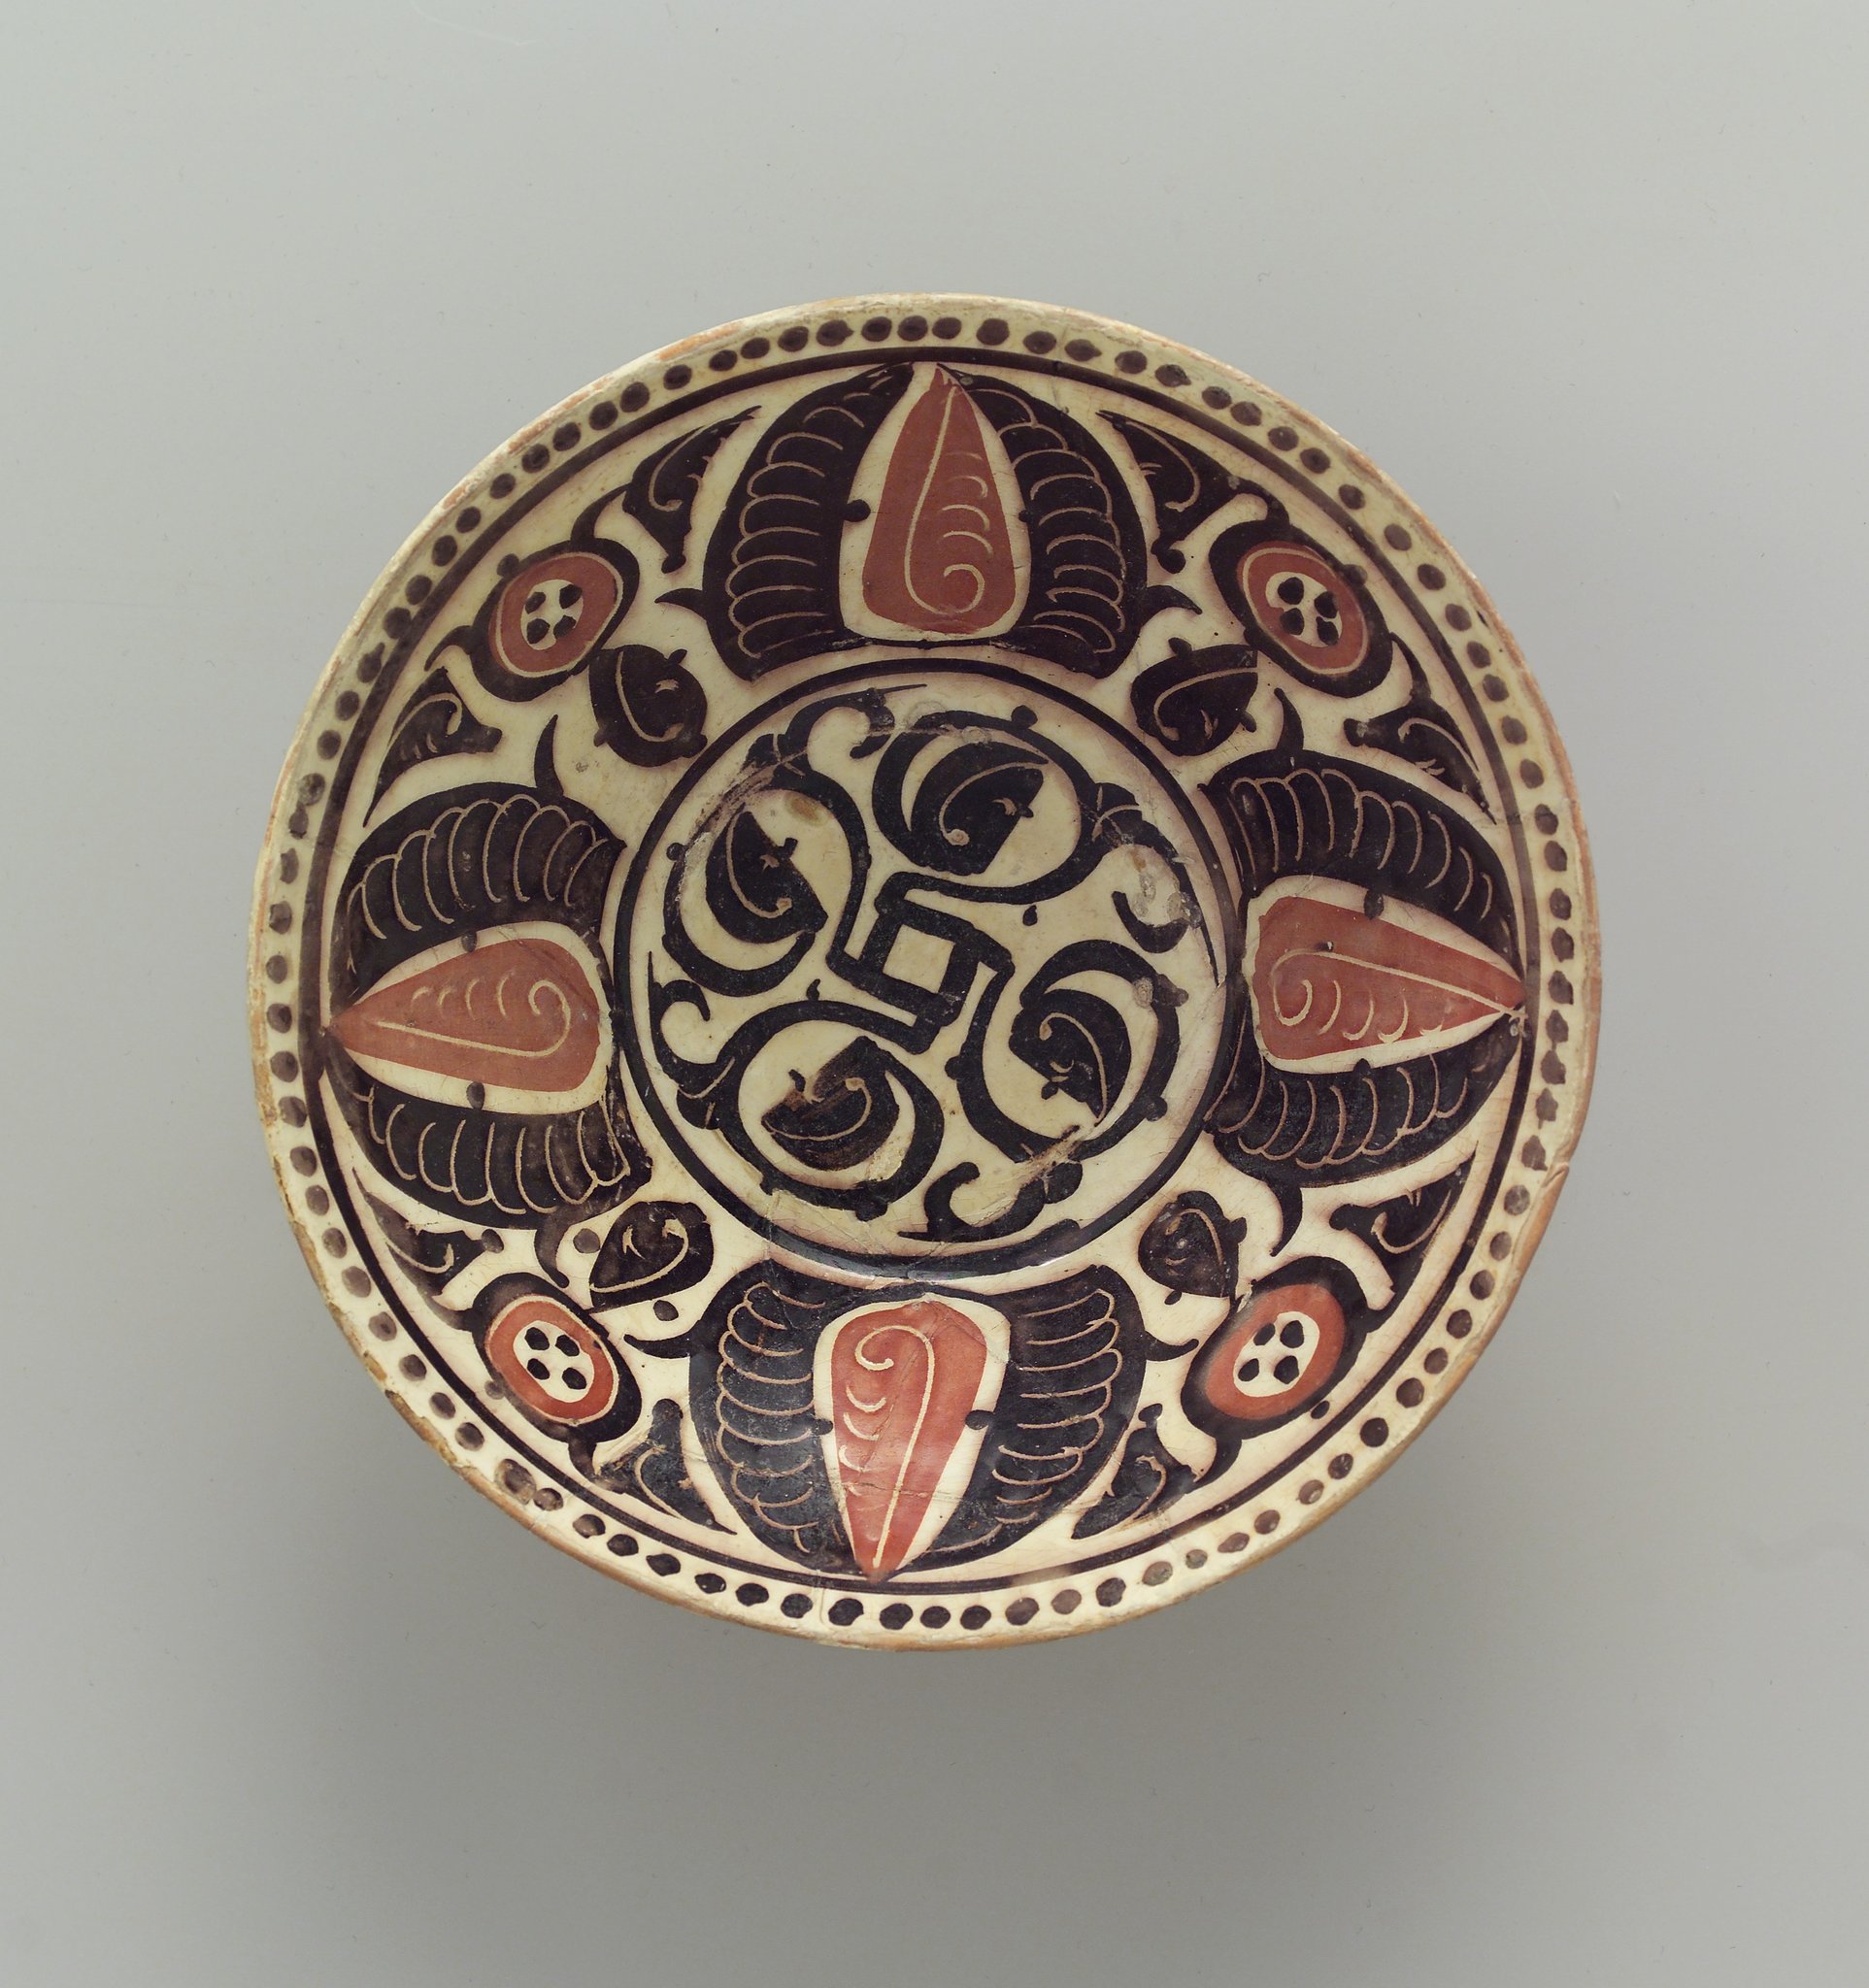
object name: bowl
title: Bowl with Red and Purplish-black Palmettes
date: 901-1100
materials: earthenware, glaze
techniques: polychrome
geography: iran